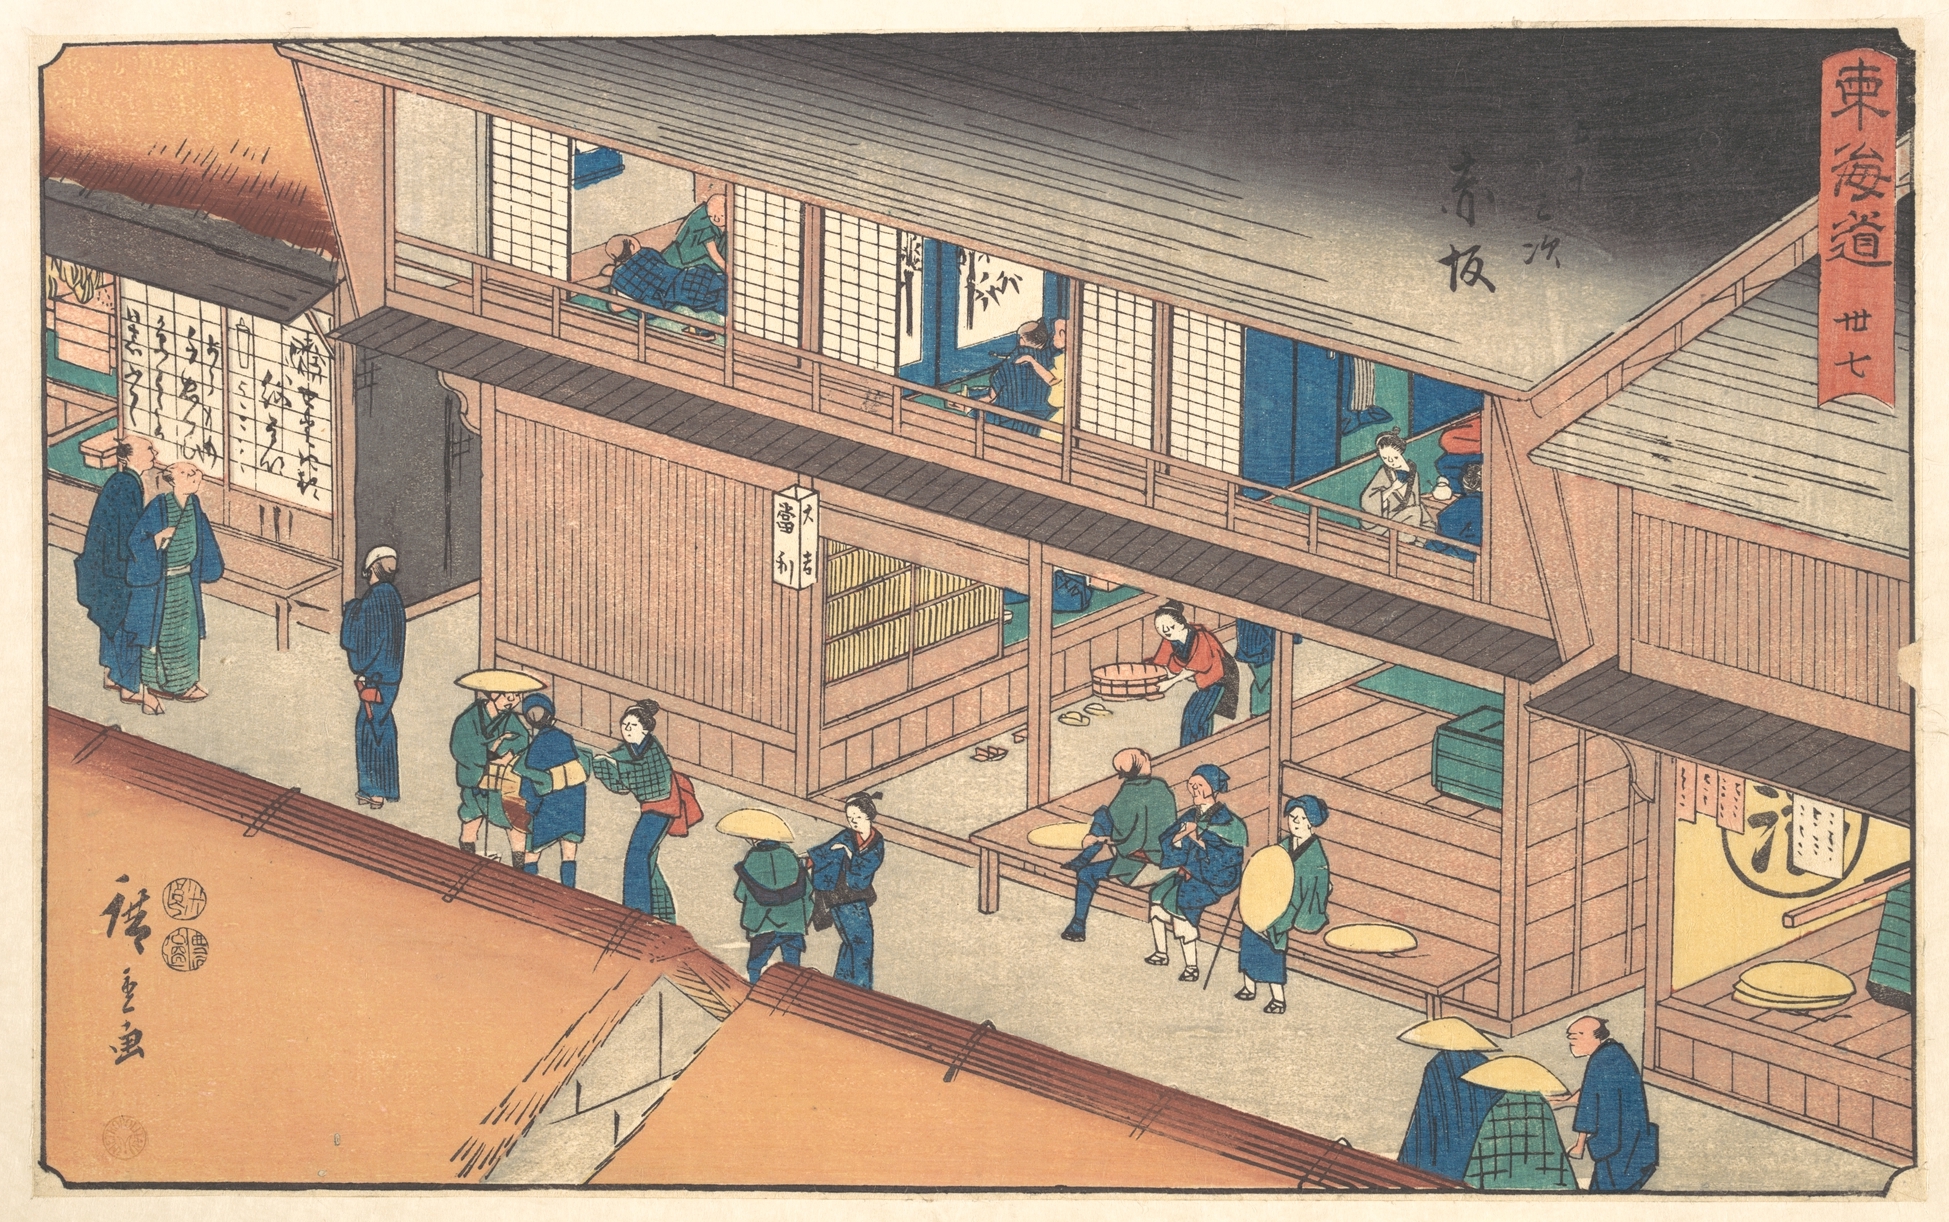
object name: print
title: Akasaka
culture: japanese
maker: utagawa hiroshige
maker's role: artist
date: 1840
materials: ink, paper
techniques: woodblock print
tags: buildings,men,women